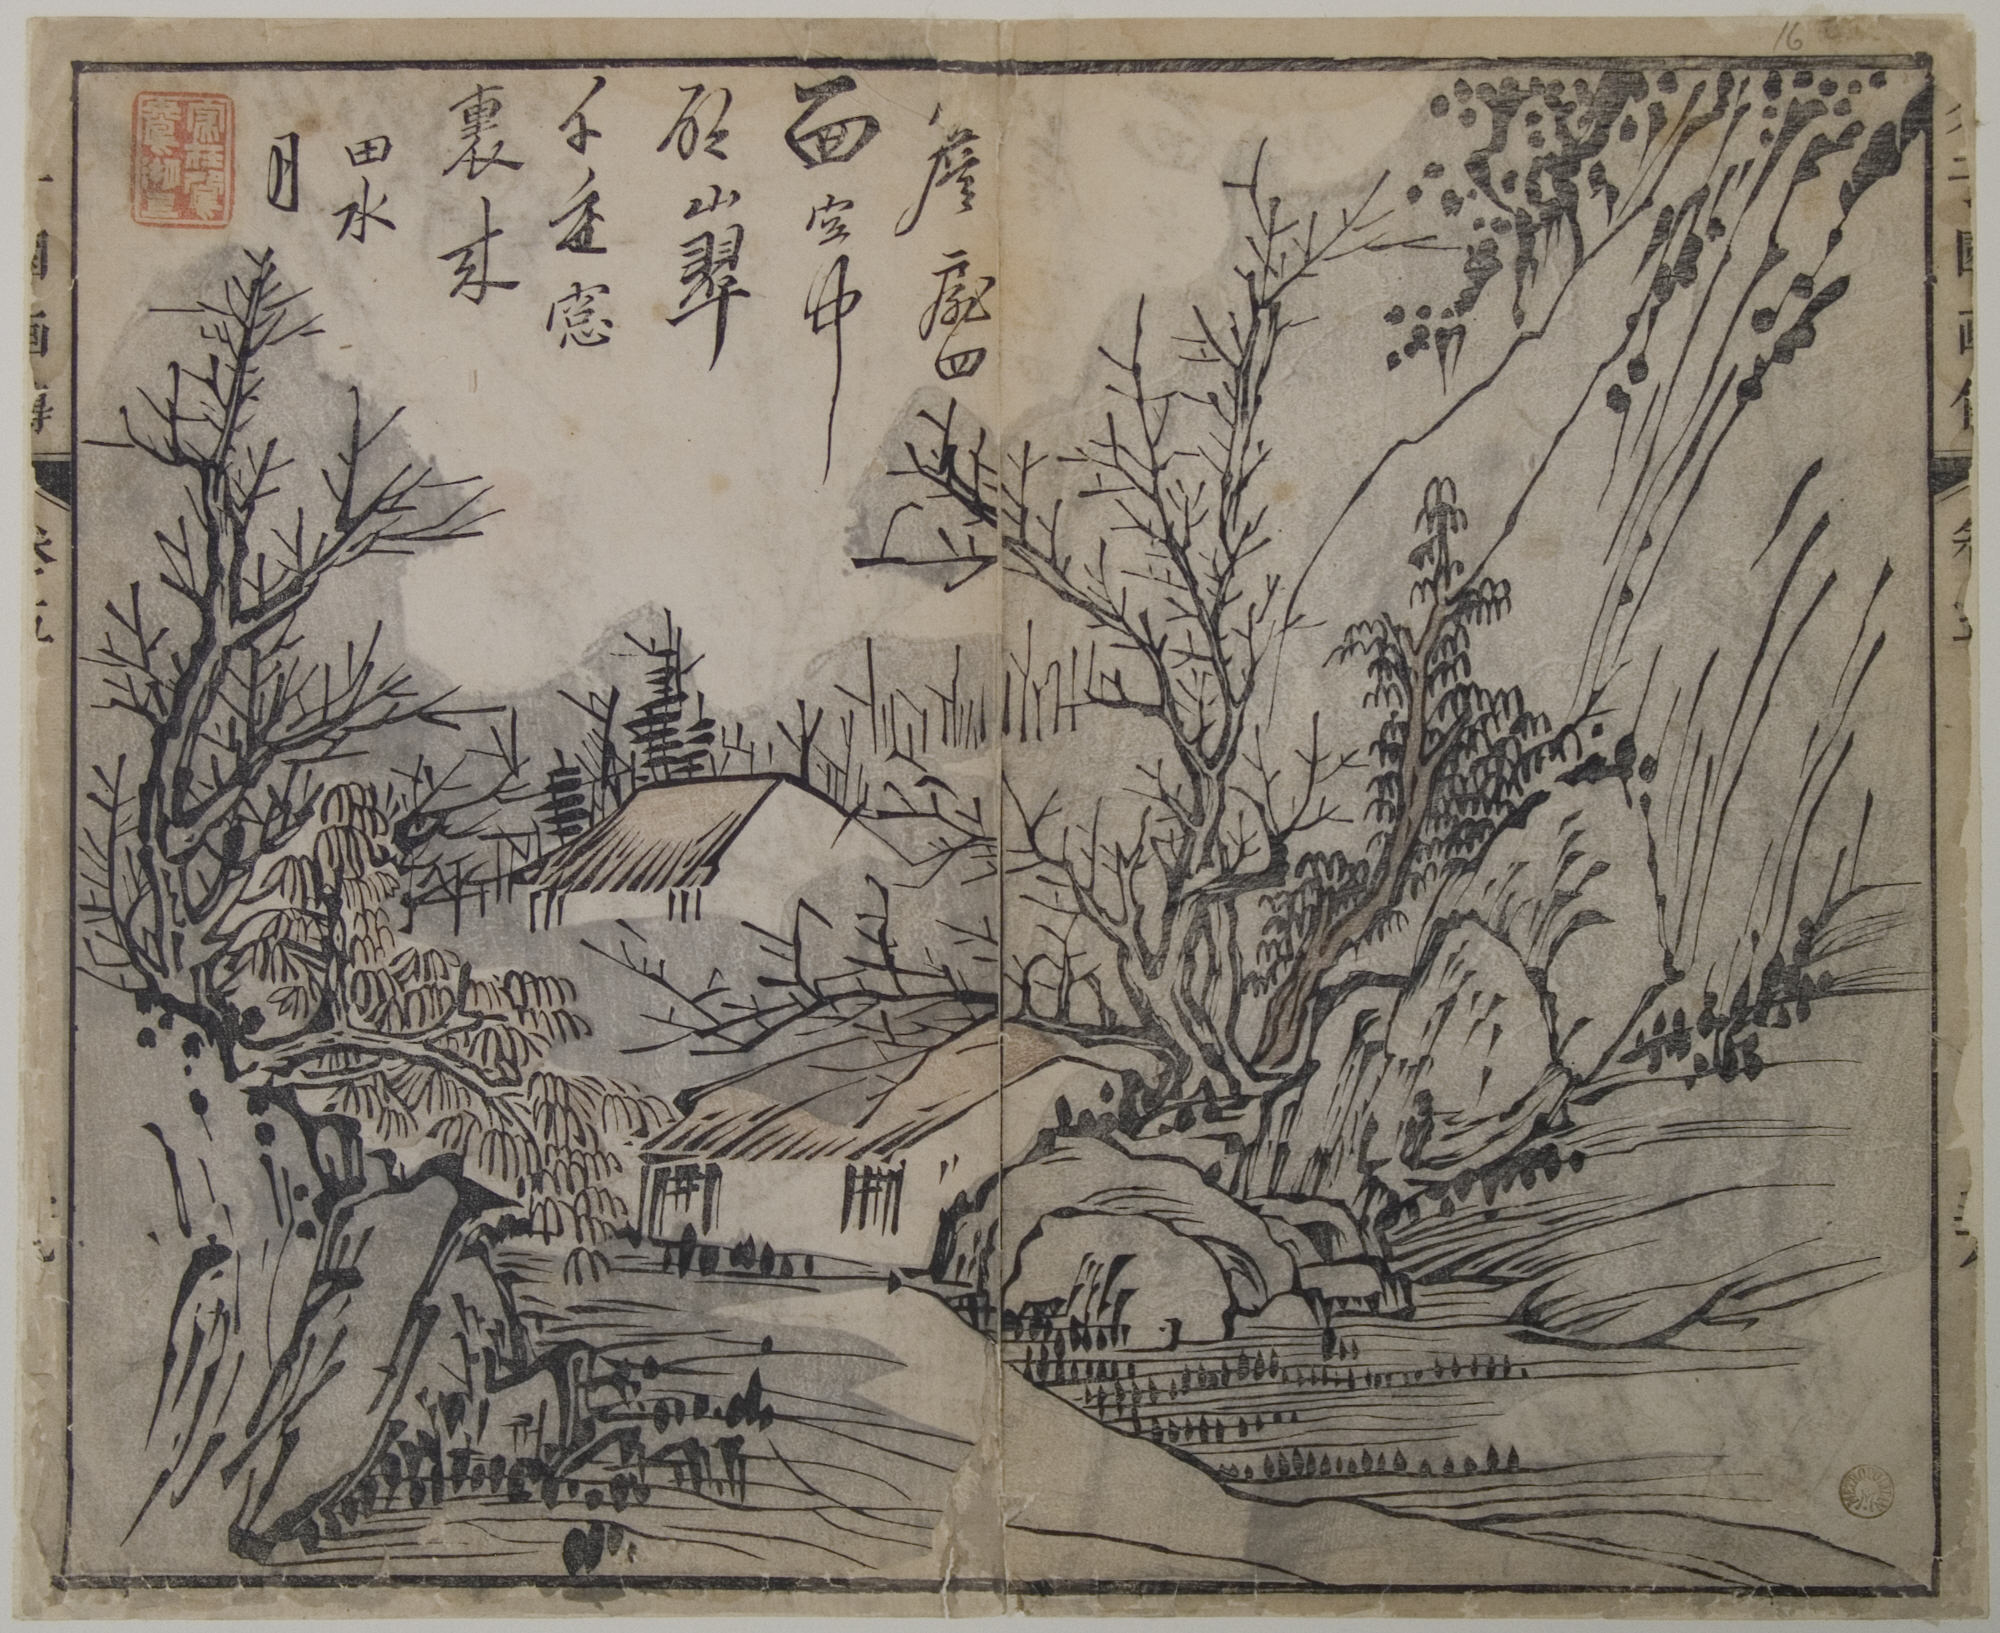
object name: print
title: Page from the Mustard Seed Garden Manual of Painting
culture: chinese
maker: wang gai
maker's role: artist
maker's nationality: chinese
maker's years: 1645-1710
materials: ink, paper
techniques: woodblock print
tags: houses,landscapes